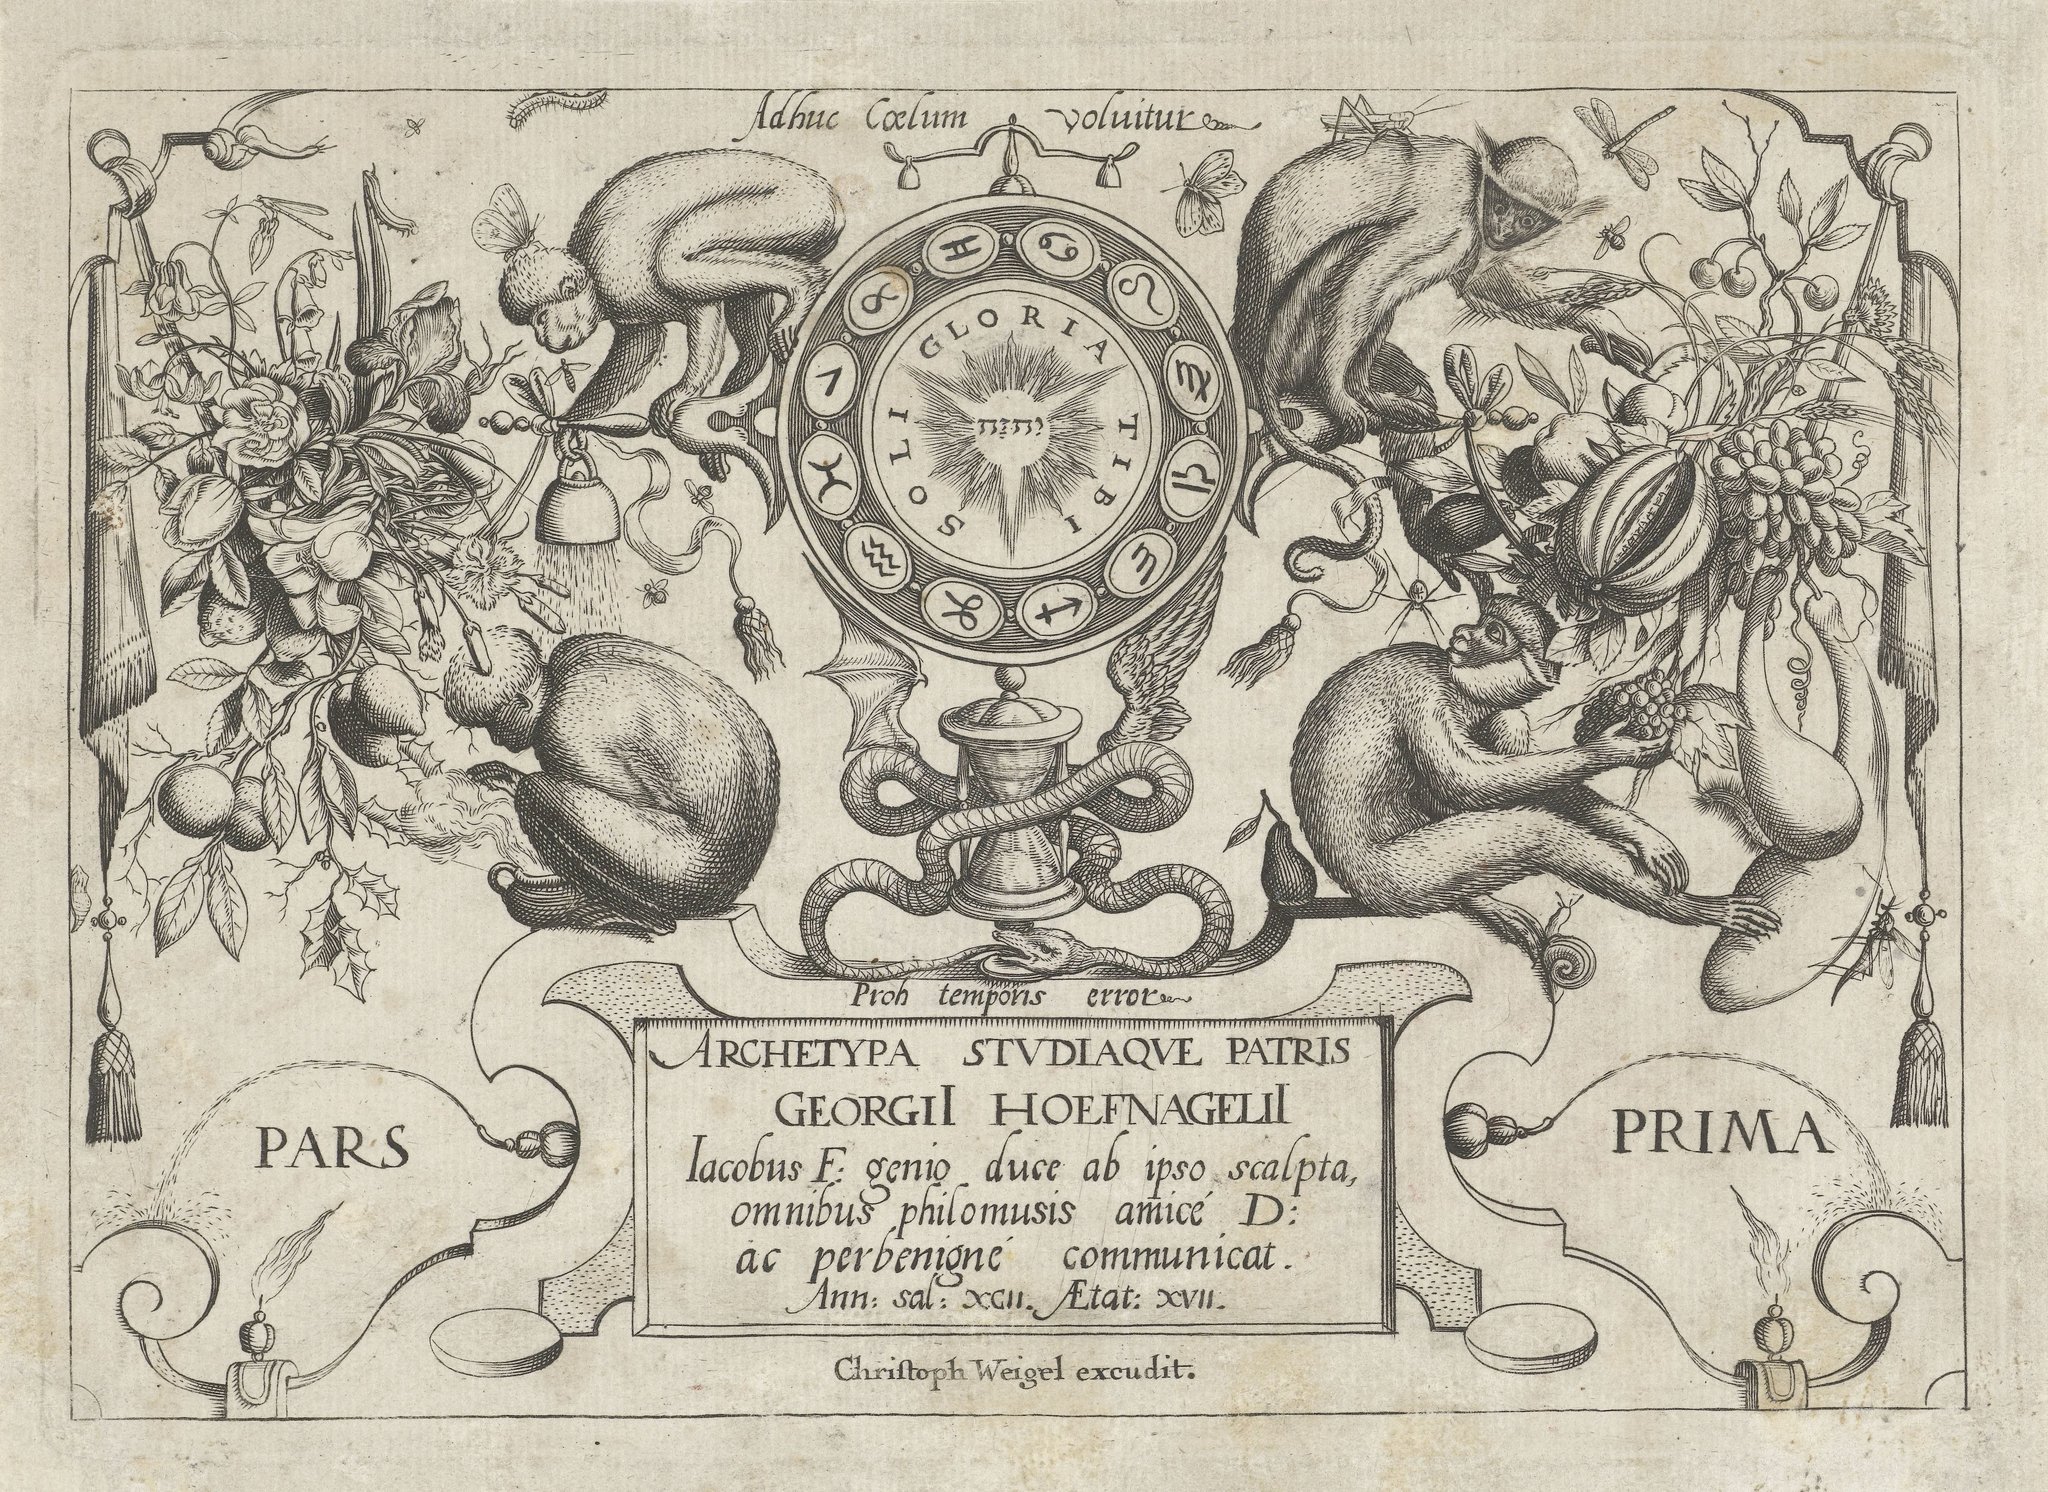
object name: print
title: Archetypa studiaque patris GeorgiI HoefnageliI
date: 1592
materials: paper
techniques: engraving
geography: nuremberg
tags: flowers, monkeys, apes, zodiac; the twelve zodiacal signs together, tetragram (in roman or hebrew script) ~ symbol of god the father, insects, fruits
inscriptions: collector's mark: Lugt 2228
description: Titelprent van zowel de gehele serie van in totaal 48 prenten en vier titelprenten met voorstellingen van dieren (voornamelijk insecten), planten (voornamelijk bloemen) en vruchten naar Joris Hoefnagel, alsook de titelprent van het eerste deel hiervan. In het midden een cirkel met daarin de twaalf symbolen van de dierenriem en een tetragram binnen een stralenkrans met de woorden: soli gloria titbi. Daaronder een slang die in zijn eigen staart bijt rond een zandloper, met op zijn rug zowel een engelen- en een duivelsvleugel. In de prent ook vier apen en in de beide bovenhoeken twee bundels met bloemen en vruchten. Onderaan de titel met aan weerskanten hiervan de woorden: pars prima. Prent uit een serie van 48, opgedeeld in vier afzonderlijke delen van elk twaalf prenten.